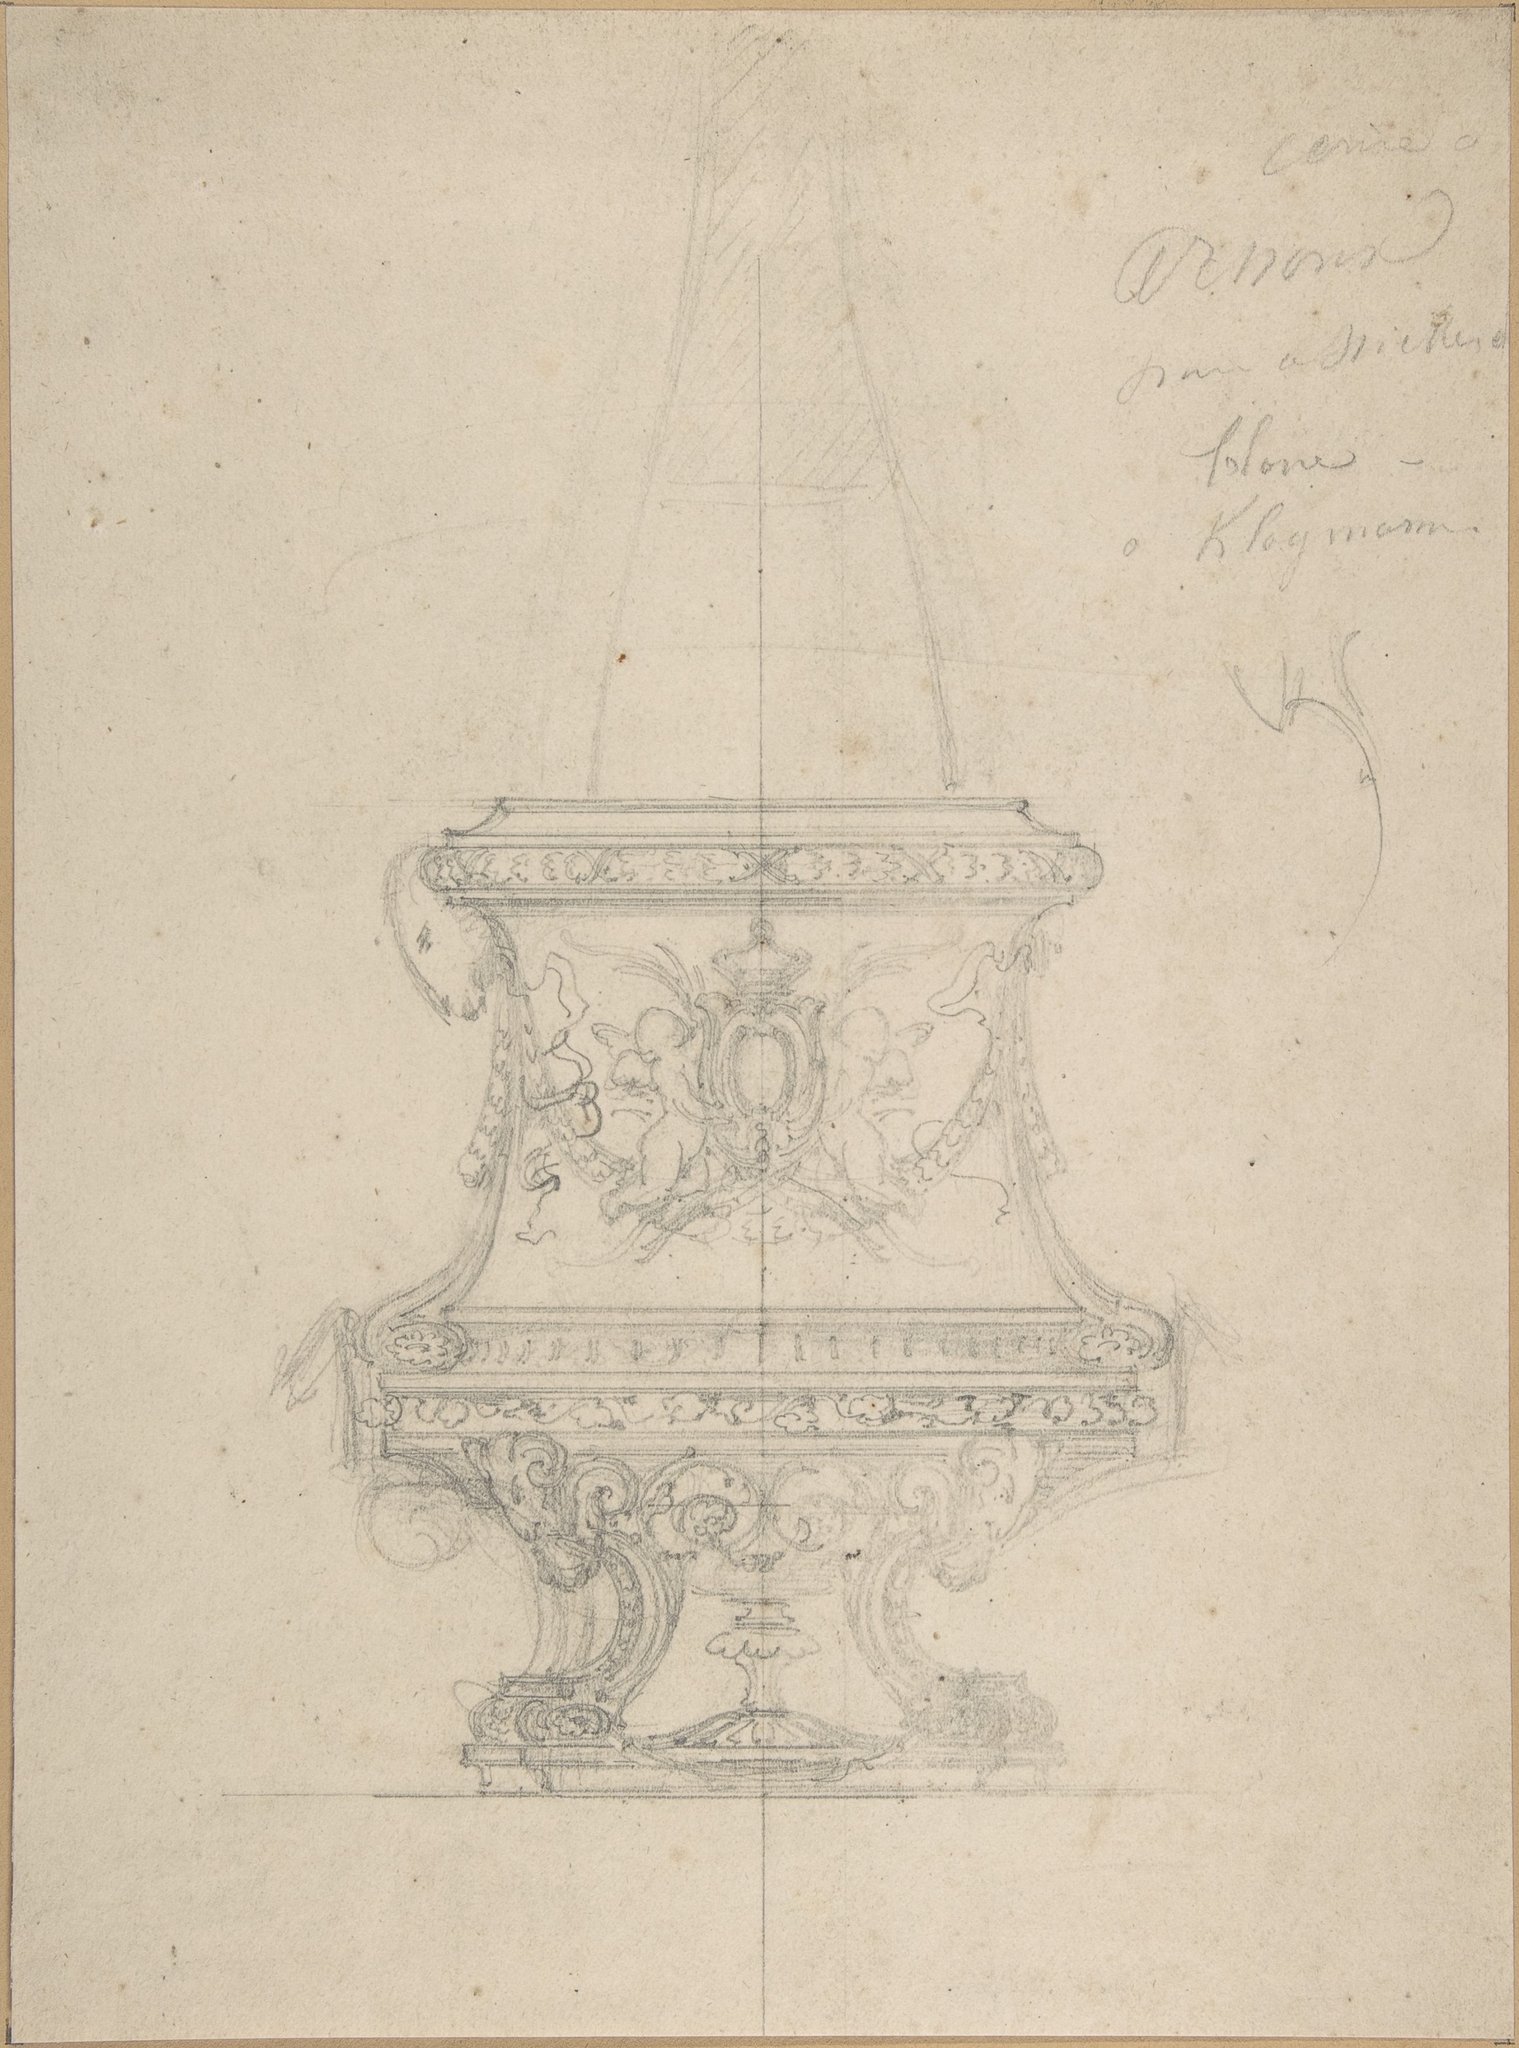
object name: drawing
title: Design for a Vase with Rams' Heads in Renaissance Style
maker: anonymous, french, 19th century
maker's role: artist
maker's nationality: french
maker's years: 1800-1900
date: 1801-1900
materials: graphite, ink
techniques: brush, pen, wash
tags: rams